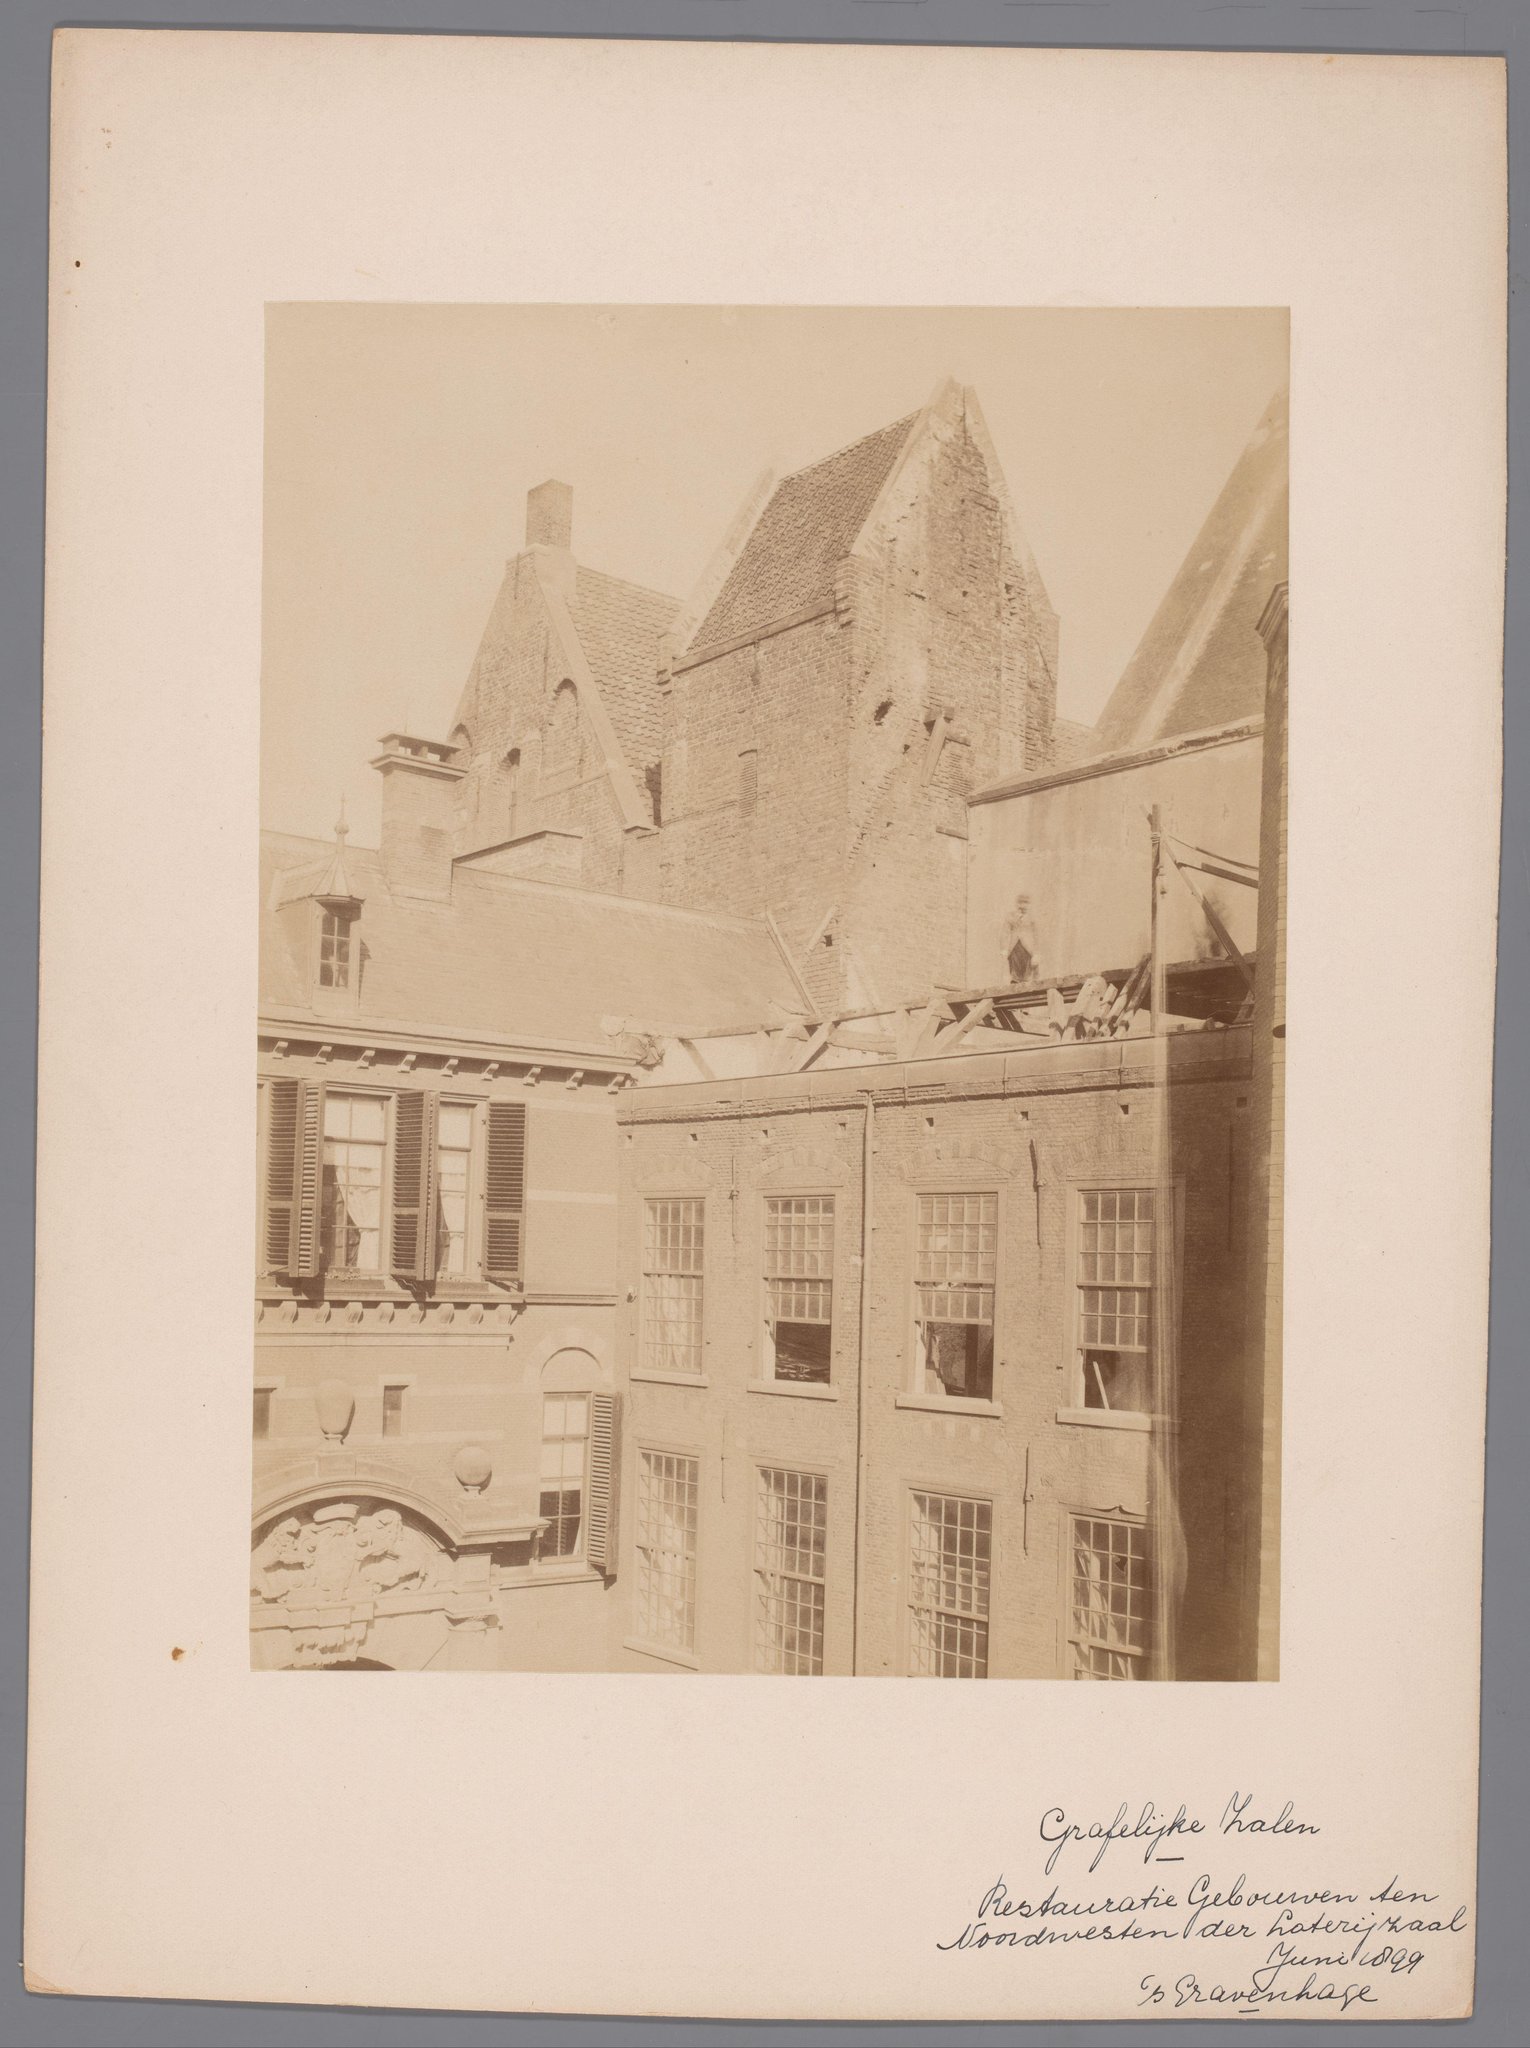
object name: photograph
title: Gezicht op gebouwen aan het Binnenhof tijdens de restauratie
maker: anoniem (monumentenzorg)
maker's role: fotograaf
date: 1899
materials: cardboard, photographic support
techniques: albumen print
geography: binnenhof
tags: urban housing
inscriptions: annotation: ‘Grafelijke Zalen/ Restauratie gebouwen ten Noordwesten der Loterij Zaal/ Juni 1899/ 's Gravenhage’, annotation: ‘'s Gravenhage Binnenhof (Z.H.)/ Gebouwen ten noord-westen der loterijzaal/ Juni 1899’